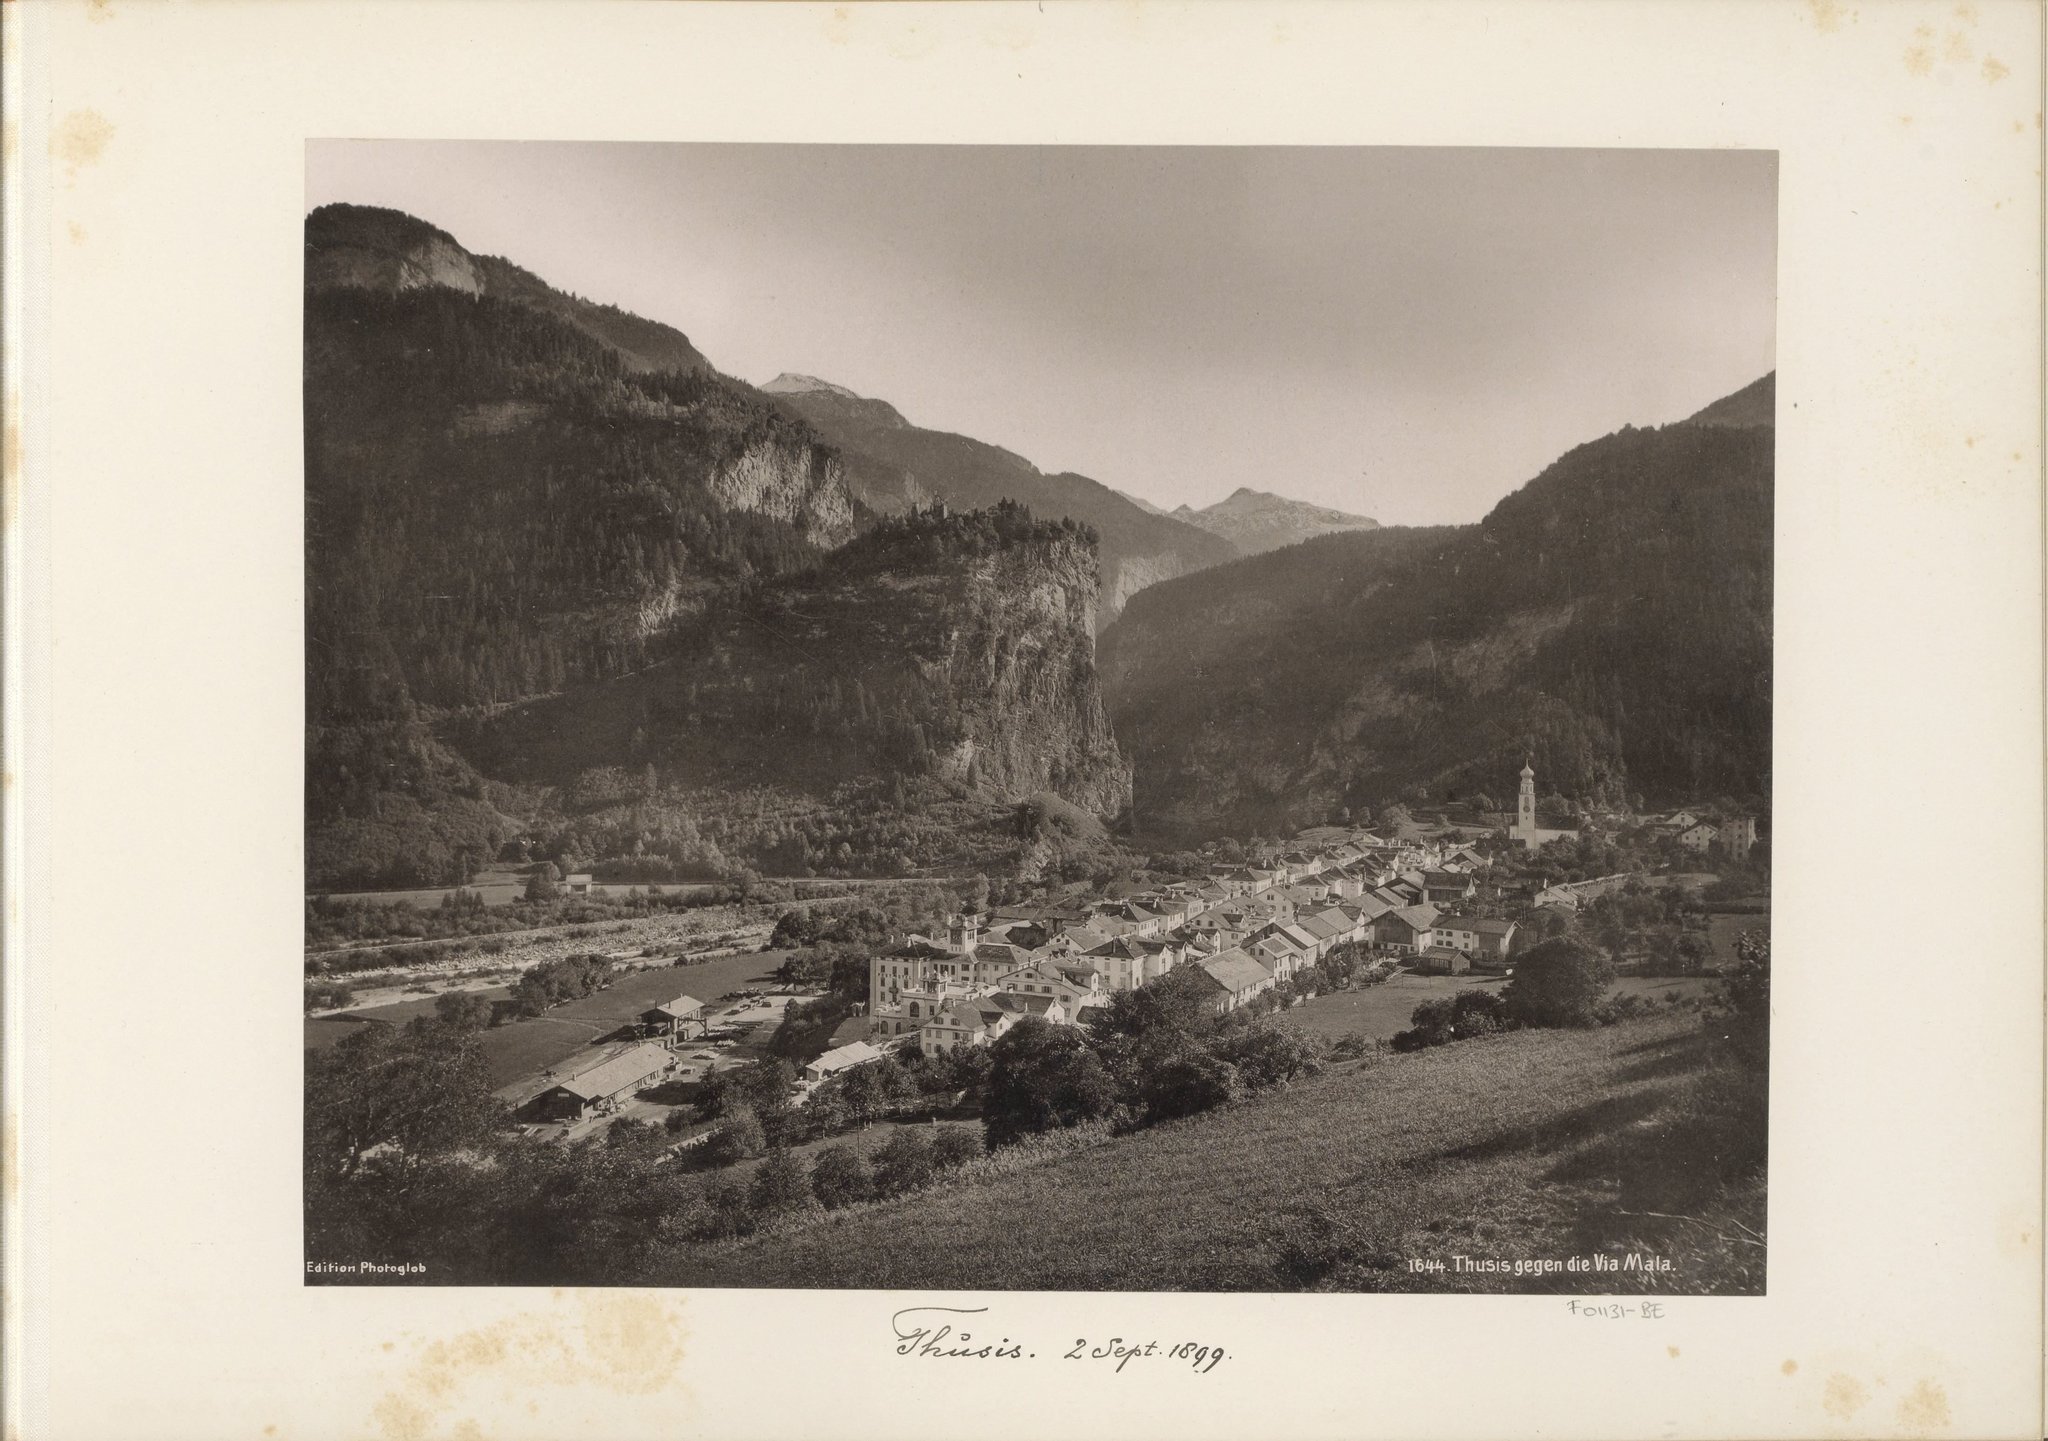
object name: photograph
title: Gezicht op Thusis en het begin van de Via Mala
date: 1880-1899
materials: paper, photographic support, ink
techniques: photograph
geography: thusis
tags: prospect of village, silhouette of village, mountains (+ landscape with figures, staffage)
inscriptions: number: ‘1644’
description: Onderdeel van Reisalbum met bezienswaardigheden in Duitsland, Oostenrijk, Zwitserland, Luxemburg en België.